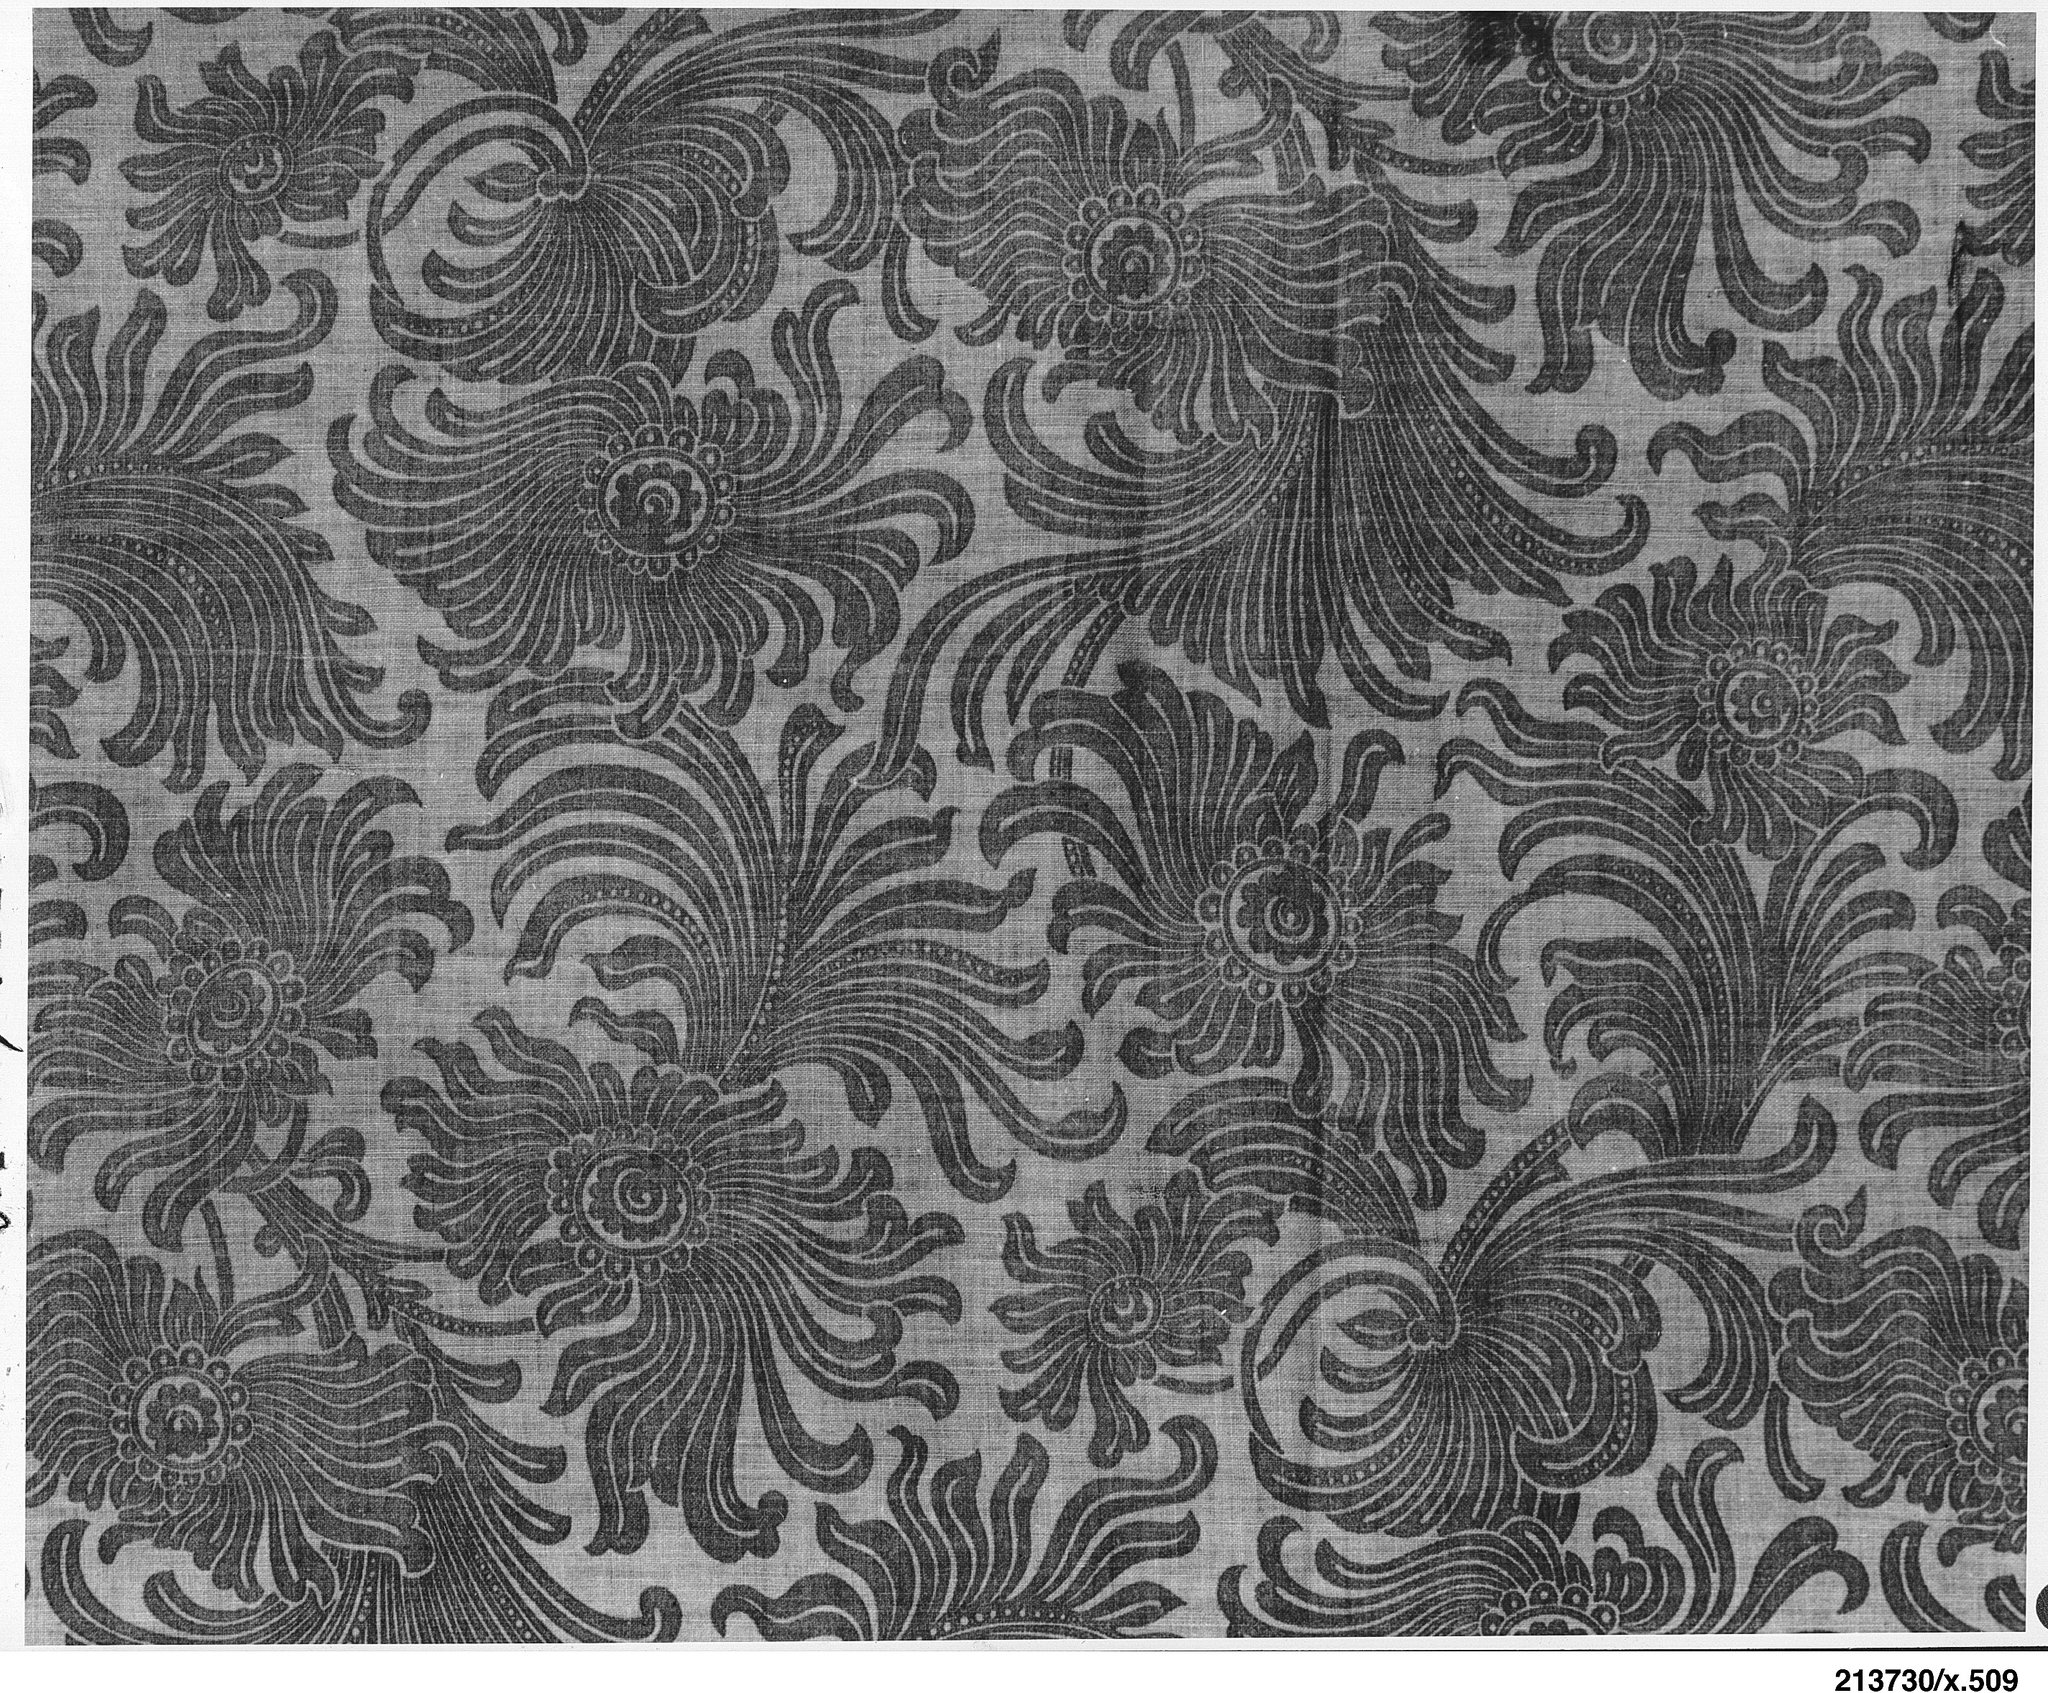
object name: piece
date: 1834-1866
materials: cotton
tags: flowers